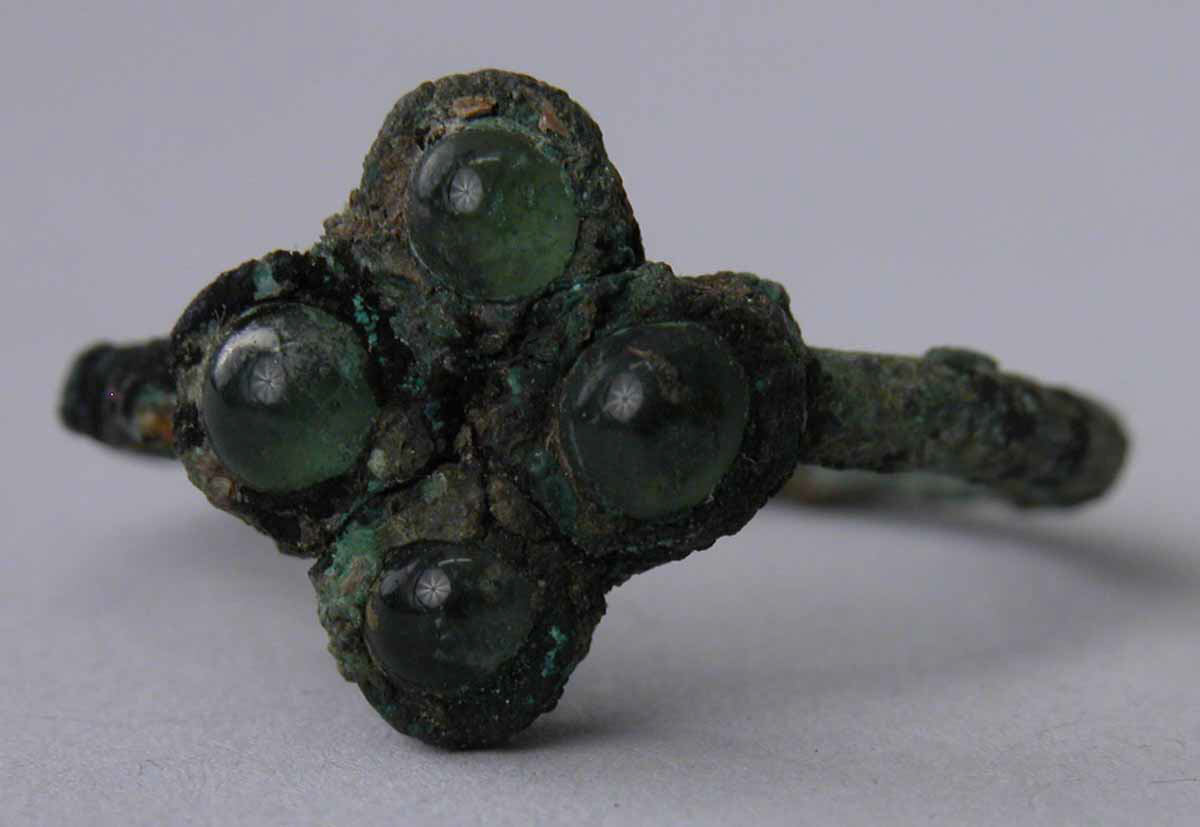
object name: ring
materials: bronze, glass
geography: egypt